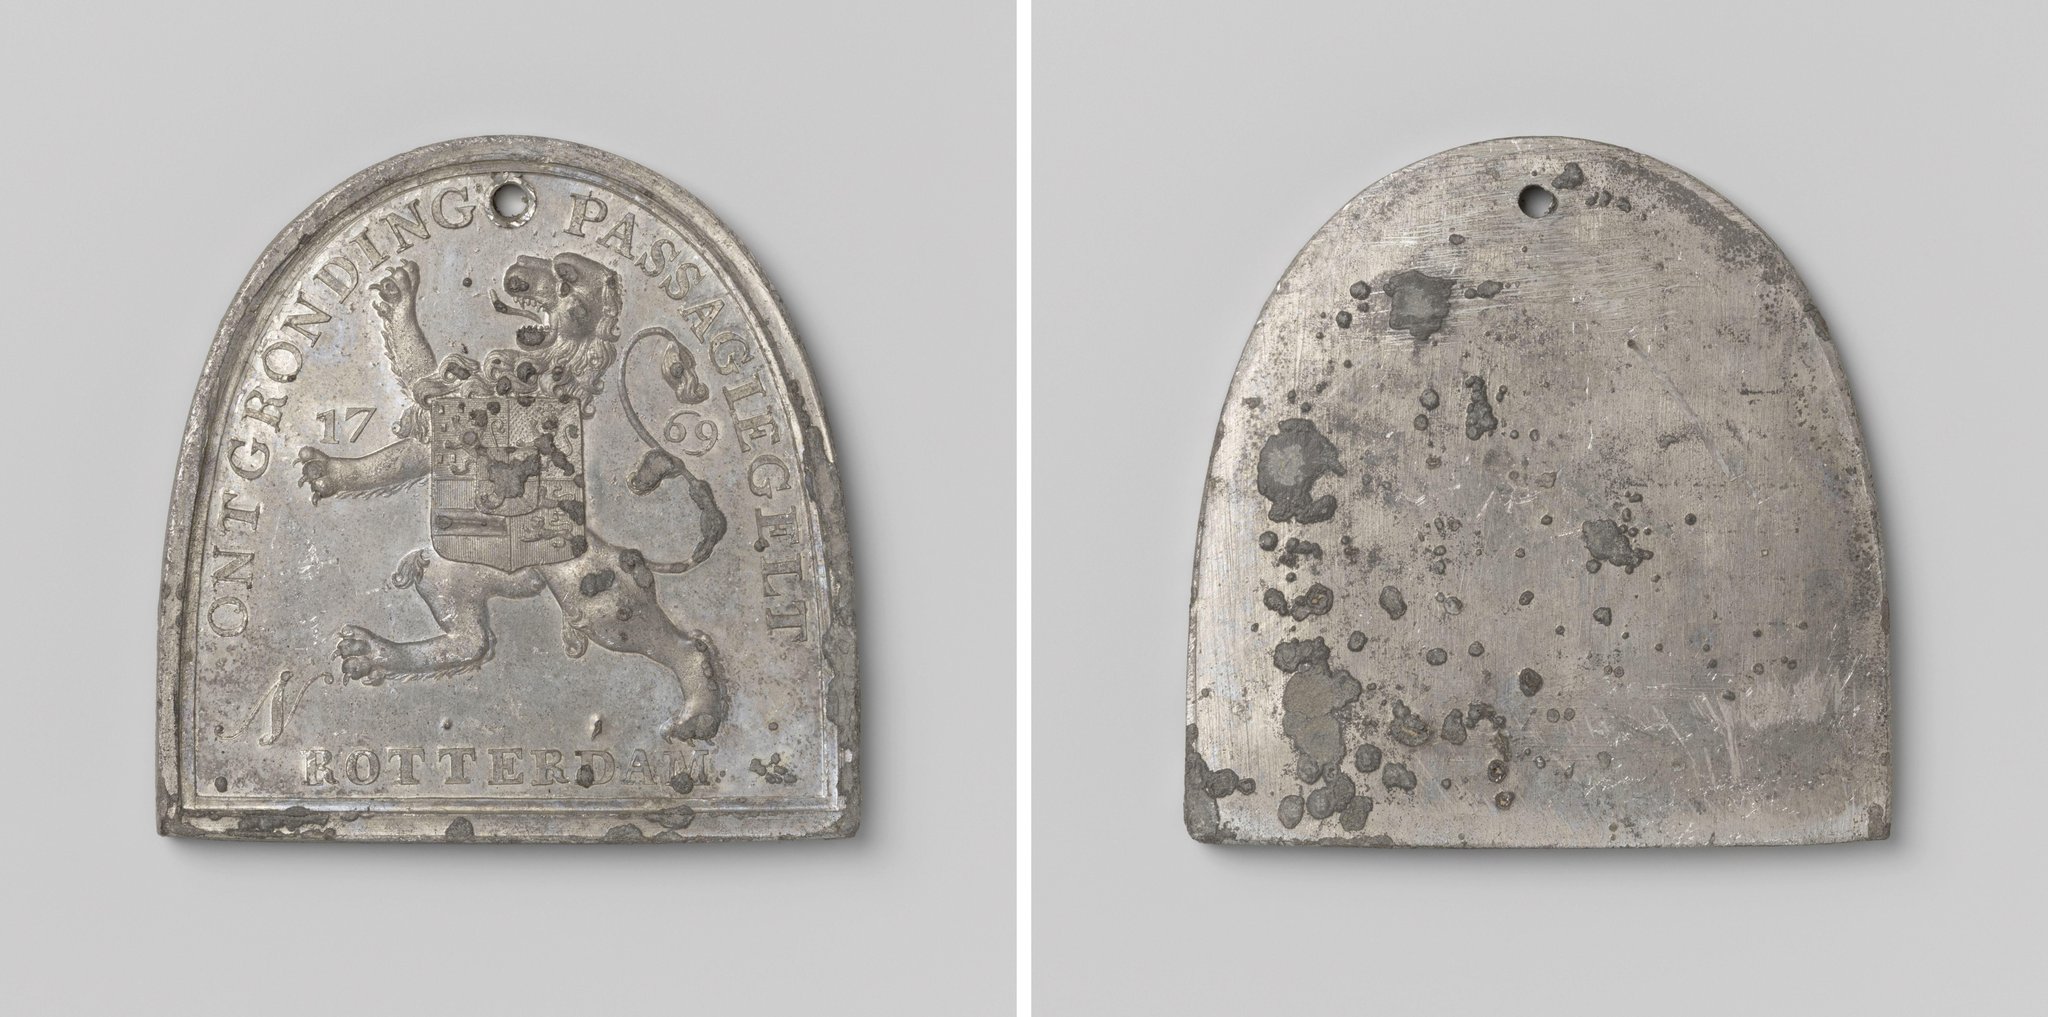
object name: ontgrondingspenning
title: Ontgronding te Rotterdam, penning bedoeld als bewijs voor turfdragers, -vullers of -tonners om turf in te mogen voeren uit de nieuw ontgronde venen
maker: Anonymous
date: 1769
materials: lead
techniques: casting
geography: rotterdam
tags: rotterdam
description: Eenzijdige loden penning met ronde boven- en rechthoekige onderzijde, en gat erin. Voorzijde: staande leeuw met wapenschild op borst tussen jaartal binnen omschrift. Keerzijde: blanco.